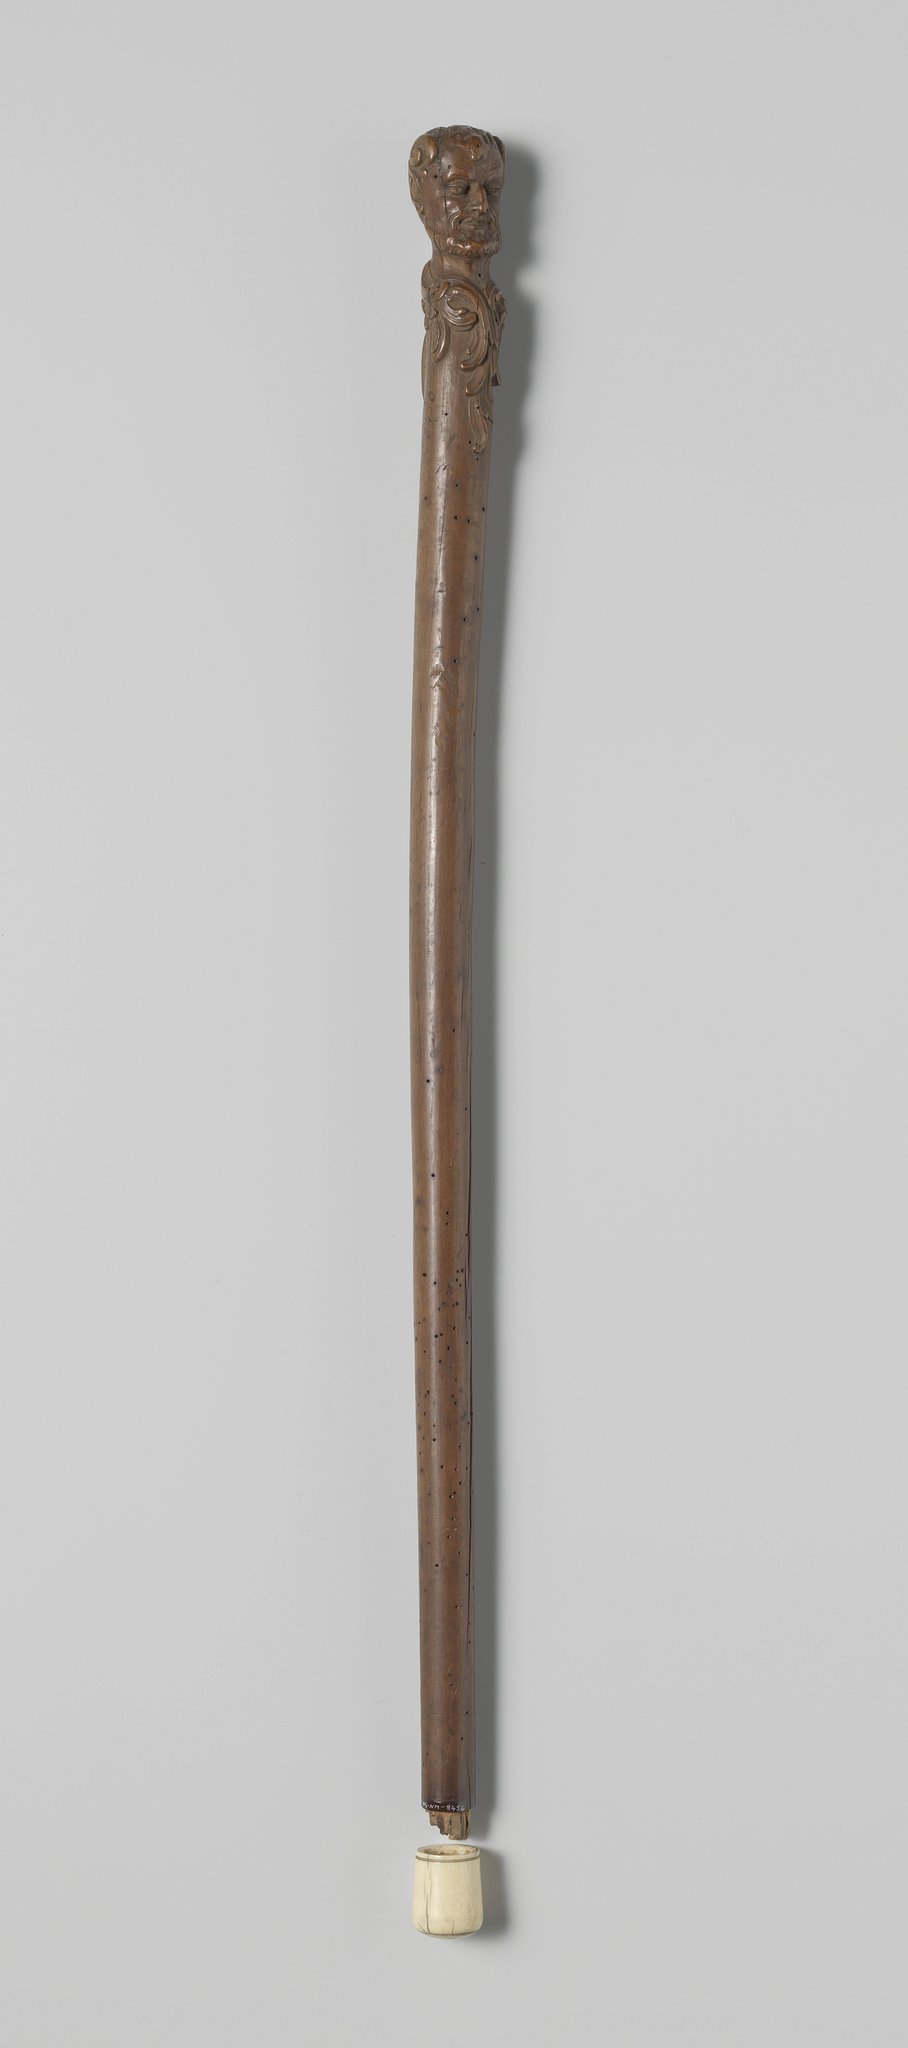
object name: womenswear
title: Wandelstok van hout met saterkop op knop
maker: Anonymous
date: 1700-1750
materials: wood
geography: europe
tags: friesland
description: Wandelstok van ijzerhout (?). De knop bestaat uit een gesneden saterkop met de stok verbonden door een ornament. Knop en stok uit één stuk.